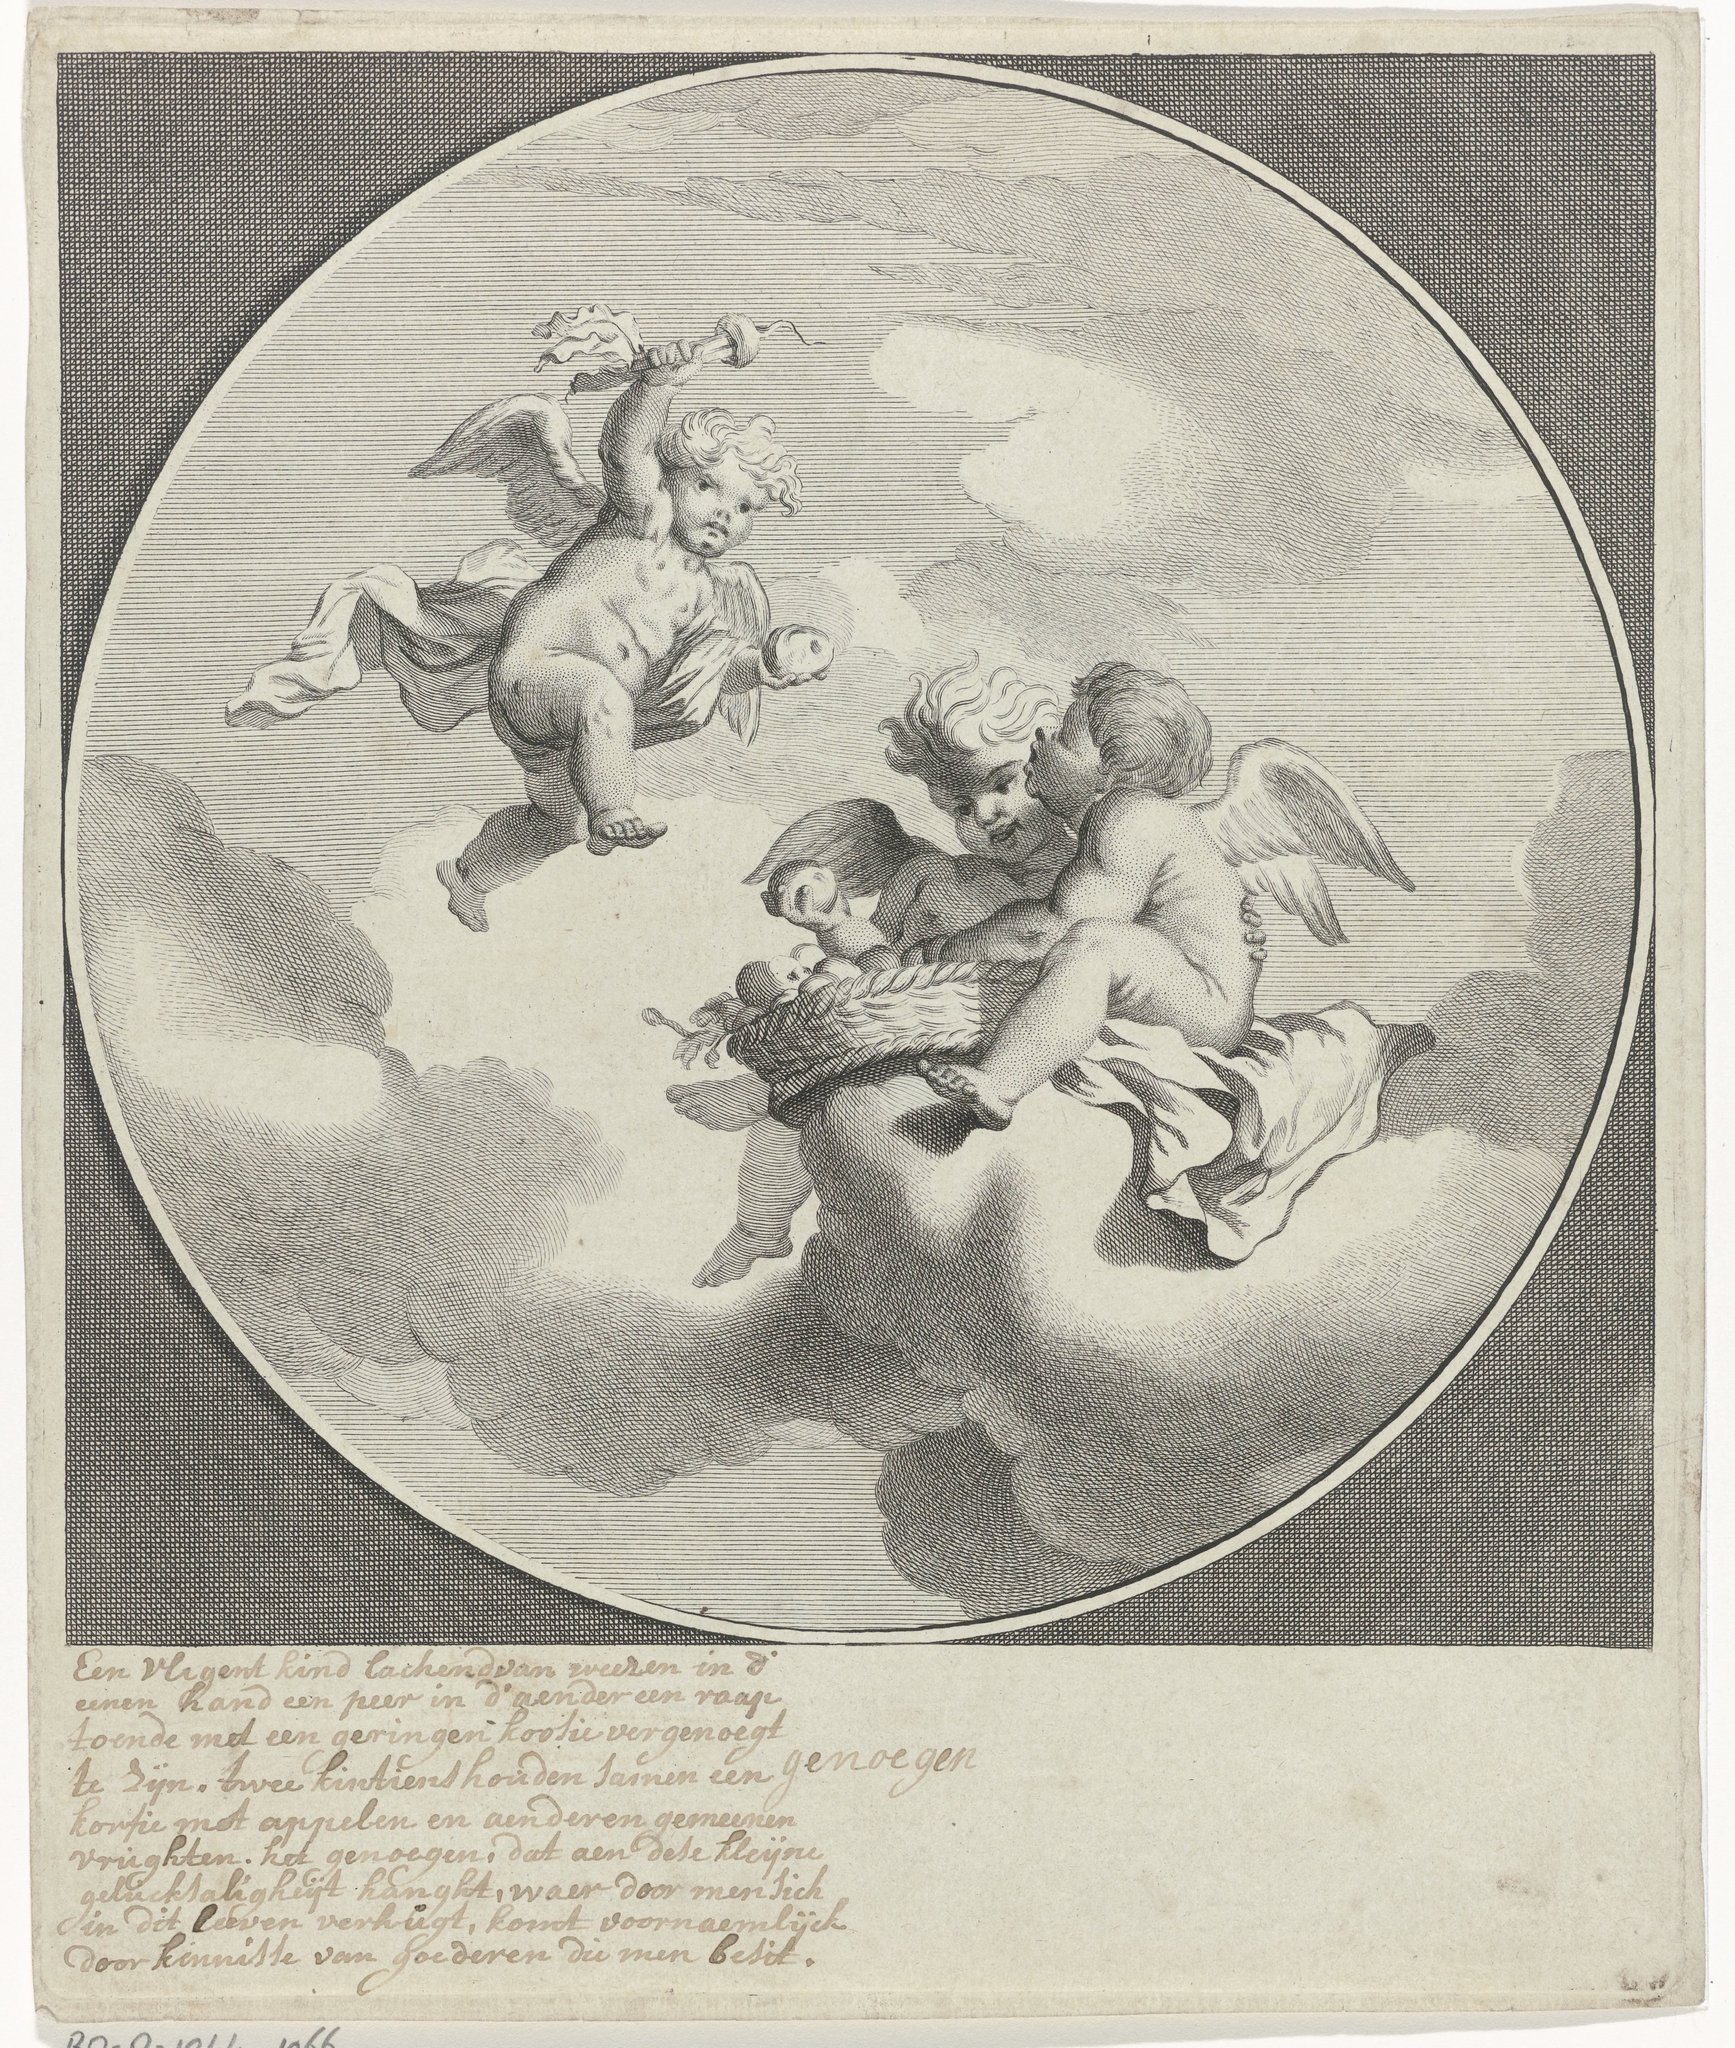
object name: print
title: Drie putti met fruitmand op de wolken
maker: Anonymous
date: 1700-1800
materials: paper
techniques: engraving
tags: cupids: 'amores', 'amoretti', 'putti'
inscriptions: inscription: ‘Een vligend kind lachend van ... van goederen die men besit.’, collector's mark: Lugt 2228